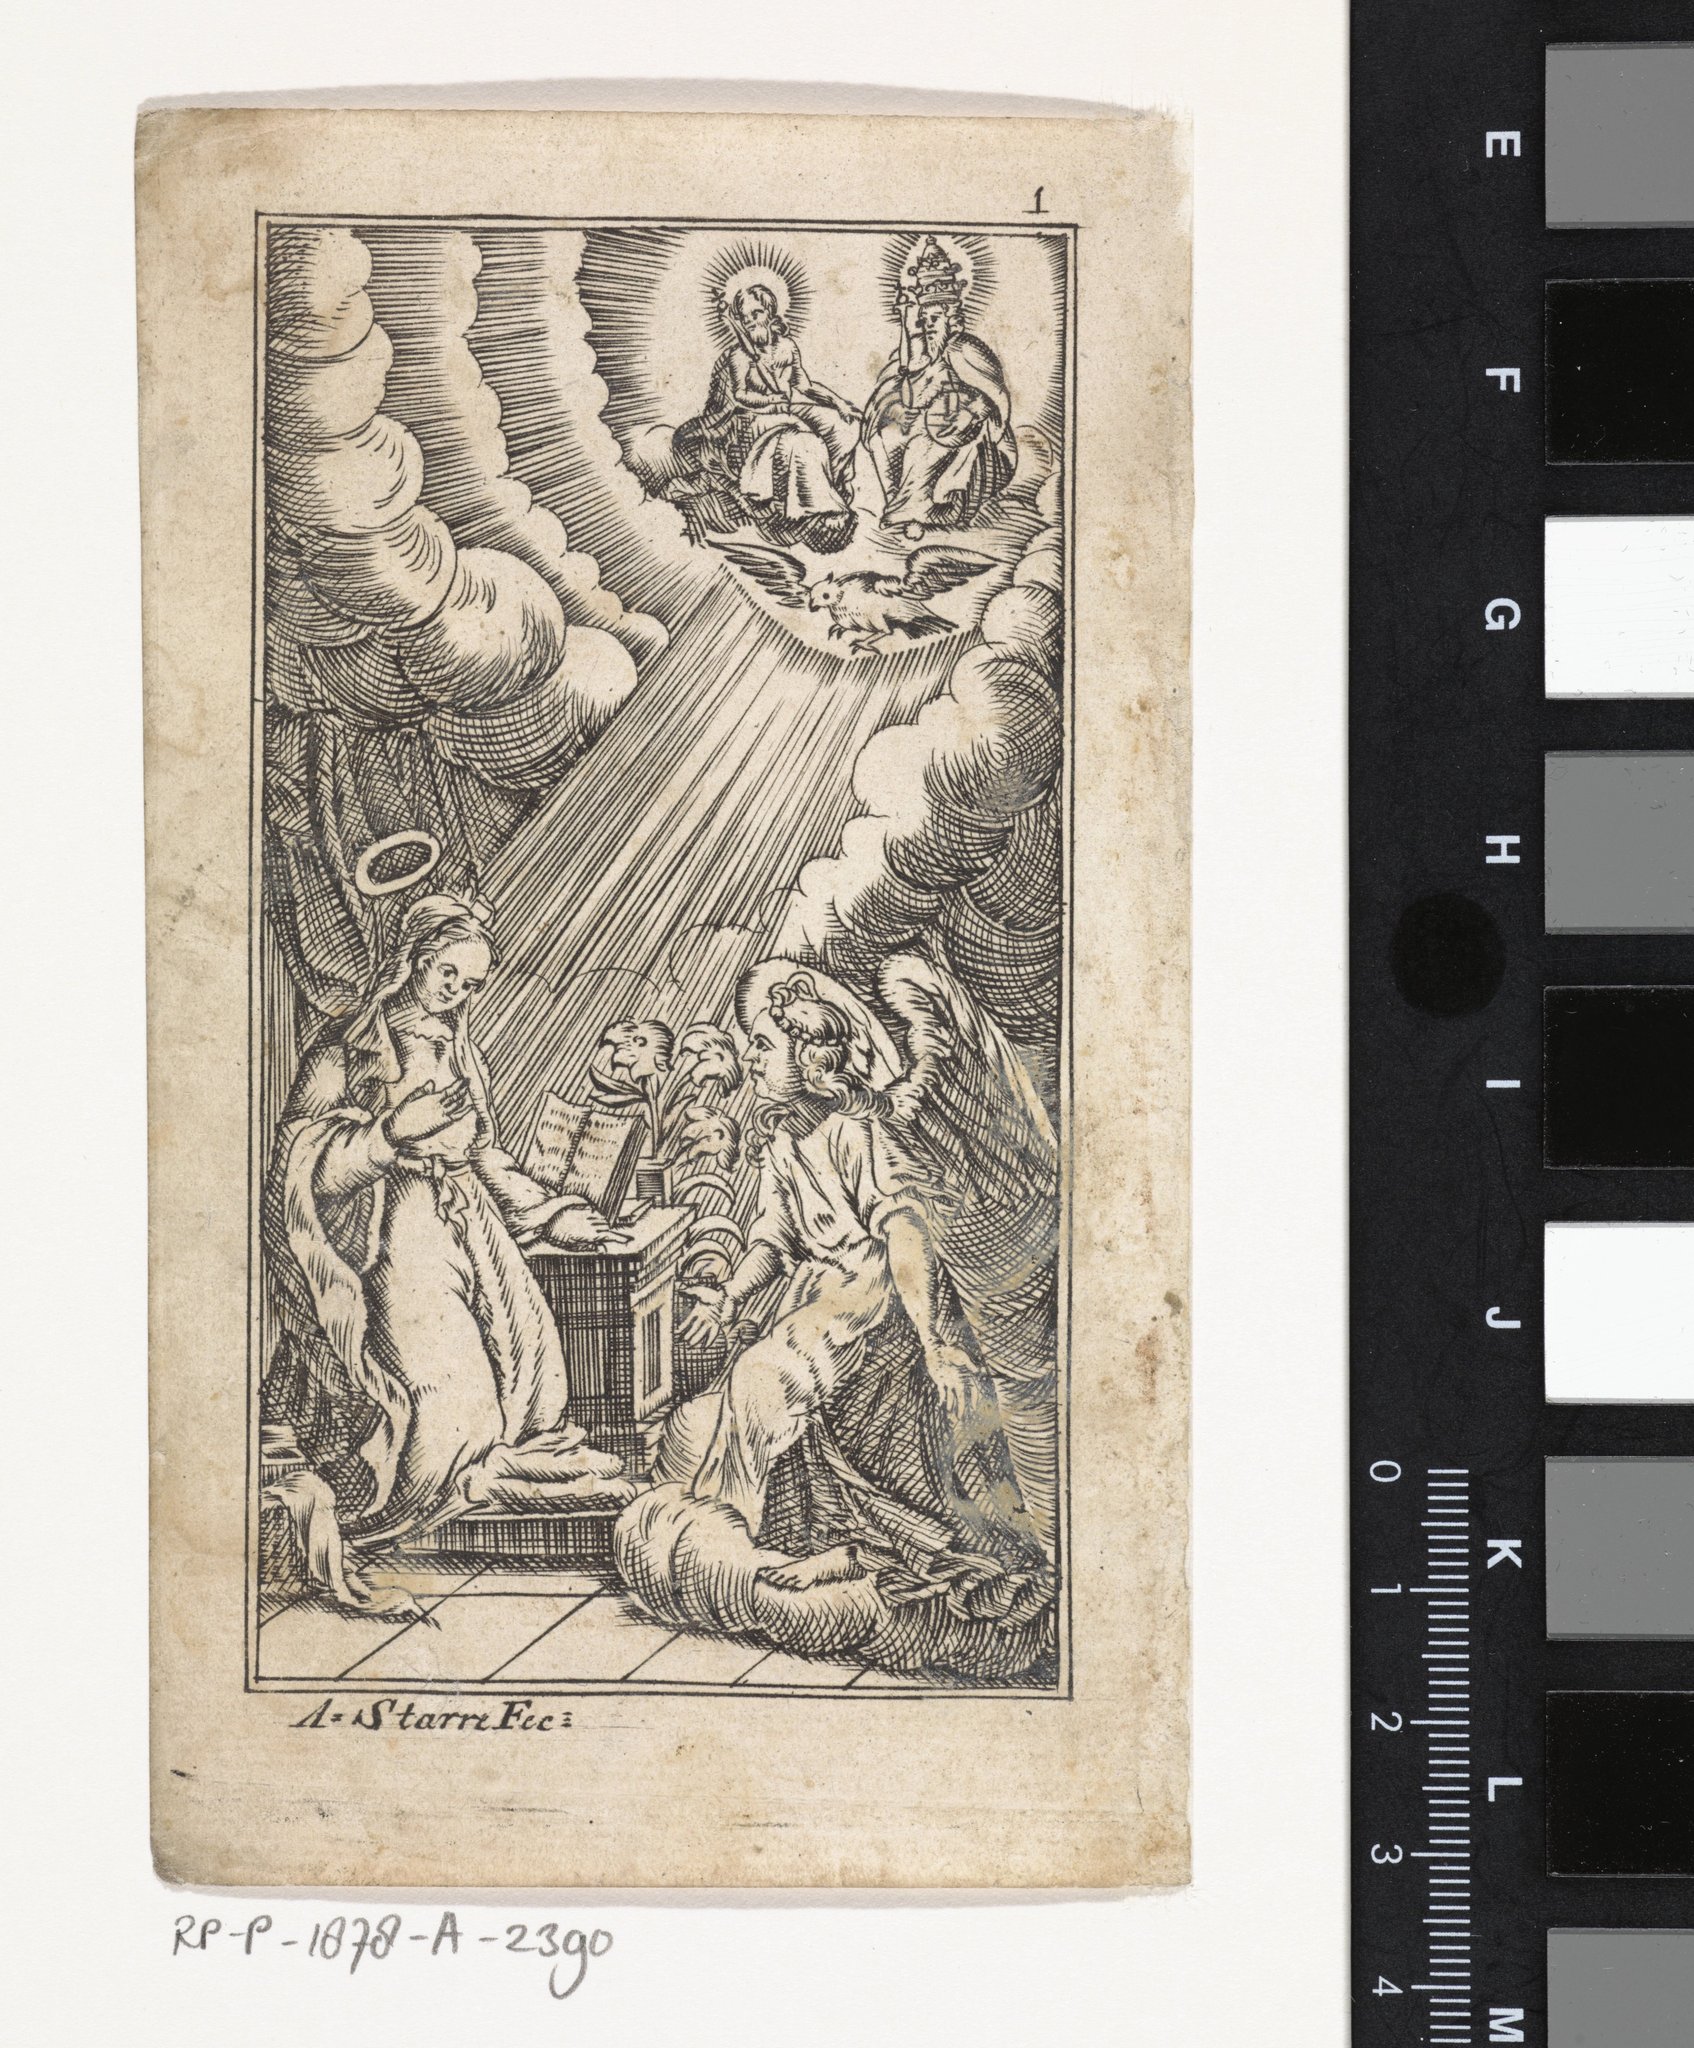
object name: print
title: Annunciatie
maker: abraham starre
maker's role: print maker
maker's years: 1701-1778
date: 1711-1778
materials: paper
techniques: engraving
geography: amsterdam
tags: the annunciation: mary kneeling - aa - mary to the left, the angel to the right (+ holy trinity)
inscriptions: collector's mark: Lugt 2228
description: De engel Gabriël kondigt Maria aan dat zij zwanger zal worden. Maria zit geknield bij haar lessenaar, waarop een boek ligt. Bovenaan de heilige Drieëenheid: God de Vader, Christus en de duif van de heilige Geest.